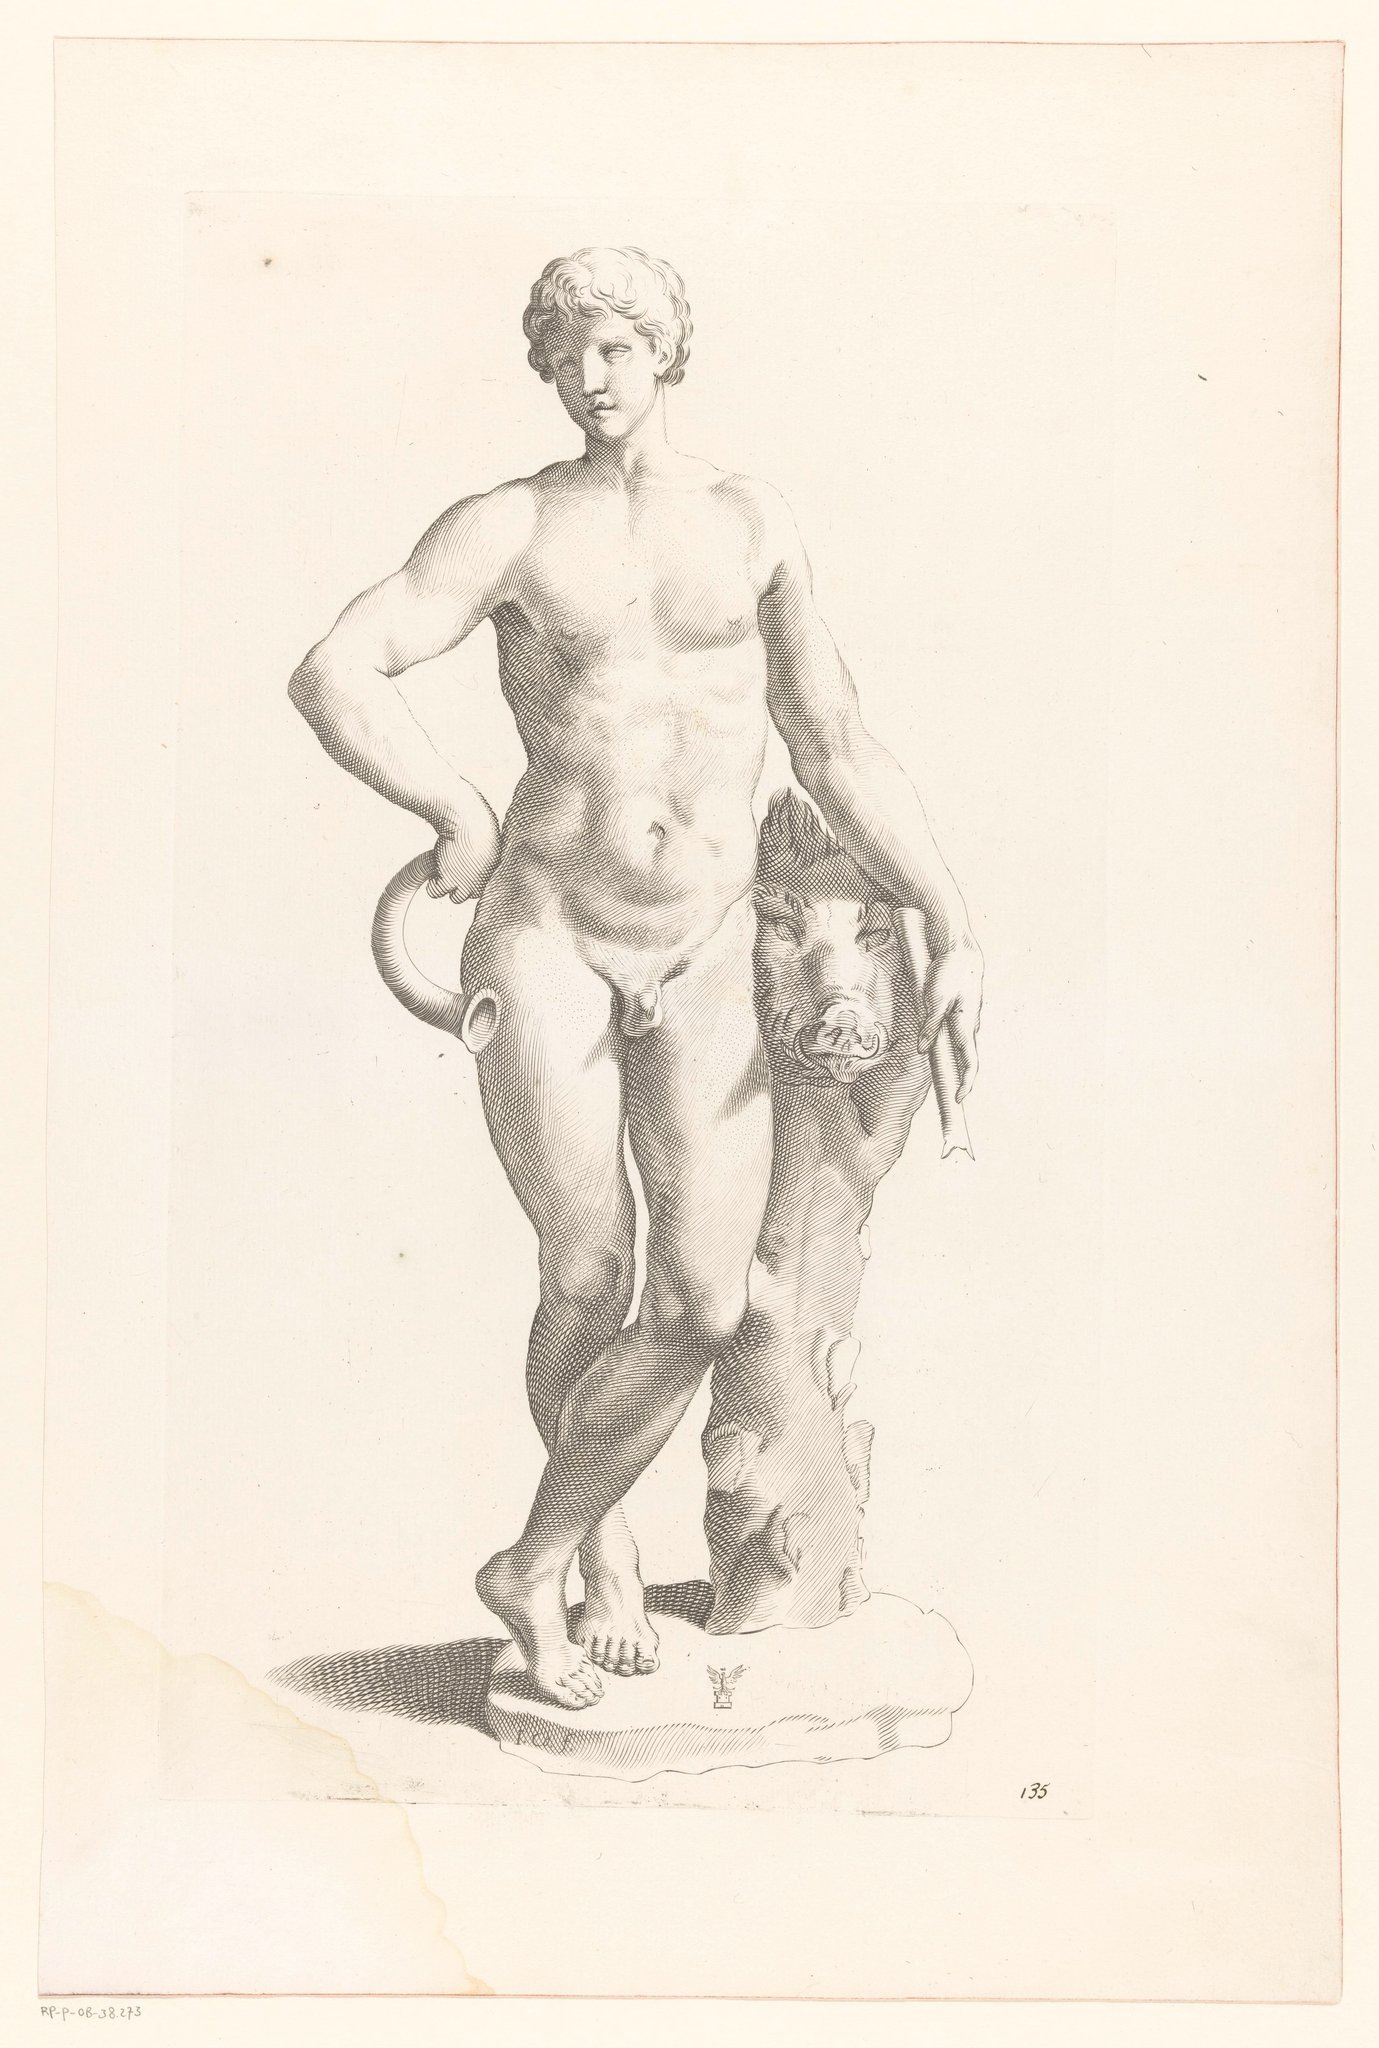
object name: print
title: Standbeeld van Meleager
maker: joan comin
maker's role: print maker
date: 1636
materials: paper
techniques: engraving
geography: rome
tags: piece of sculpture, reproduction of a piece of sculpture, (story of) meleager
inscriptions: collector's mark: Lugt 2228, number: ‘135’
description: Standbeeld van Meleager met jachthoorn in de hand naast de kop van het Caledonische zwijn. Midden onder op de basis het wapen van Vincenzo Giustiniani. Prent maakt deel uit van een serie prenten naar sculpturen in de verzameling van Giustiniani te Rome.